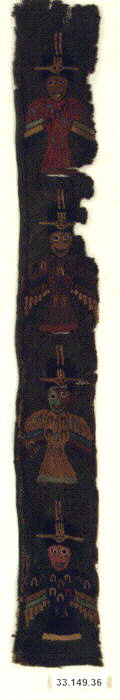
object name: border fragment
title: Embroidered Border Fragment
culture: paracas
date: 400-101 BCE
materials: animal fiber, cotton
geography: peru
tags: mythical creatures